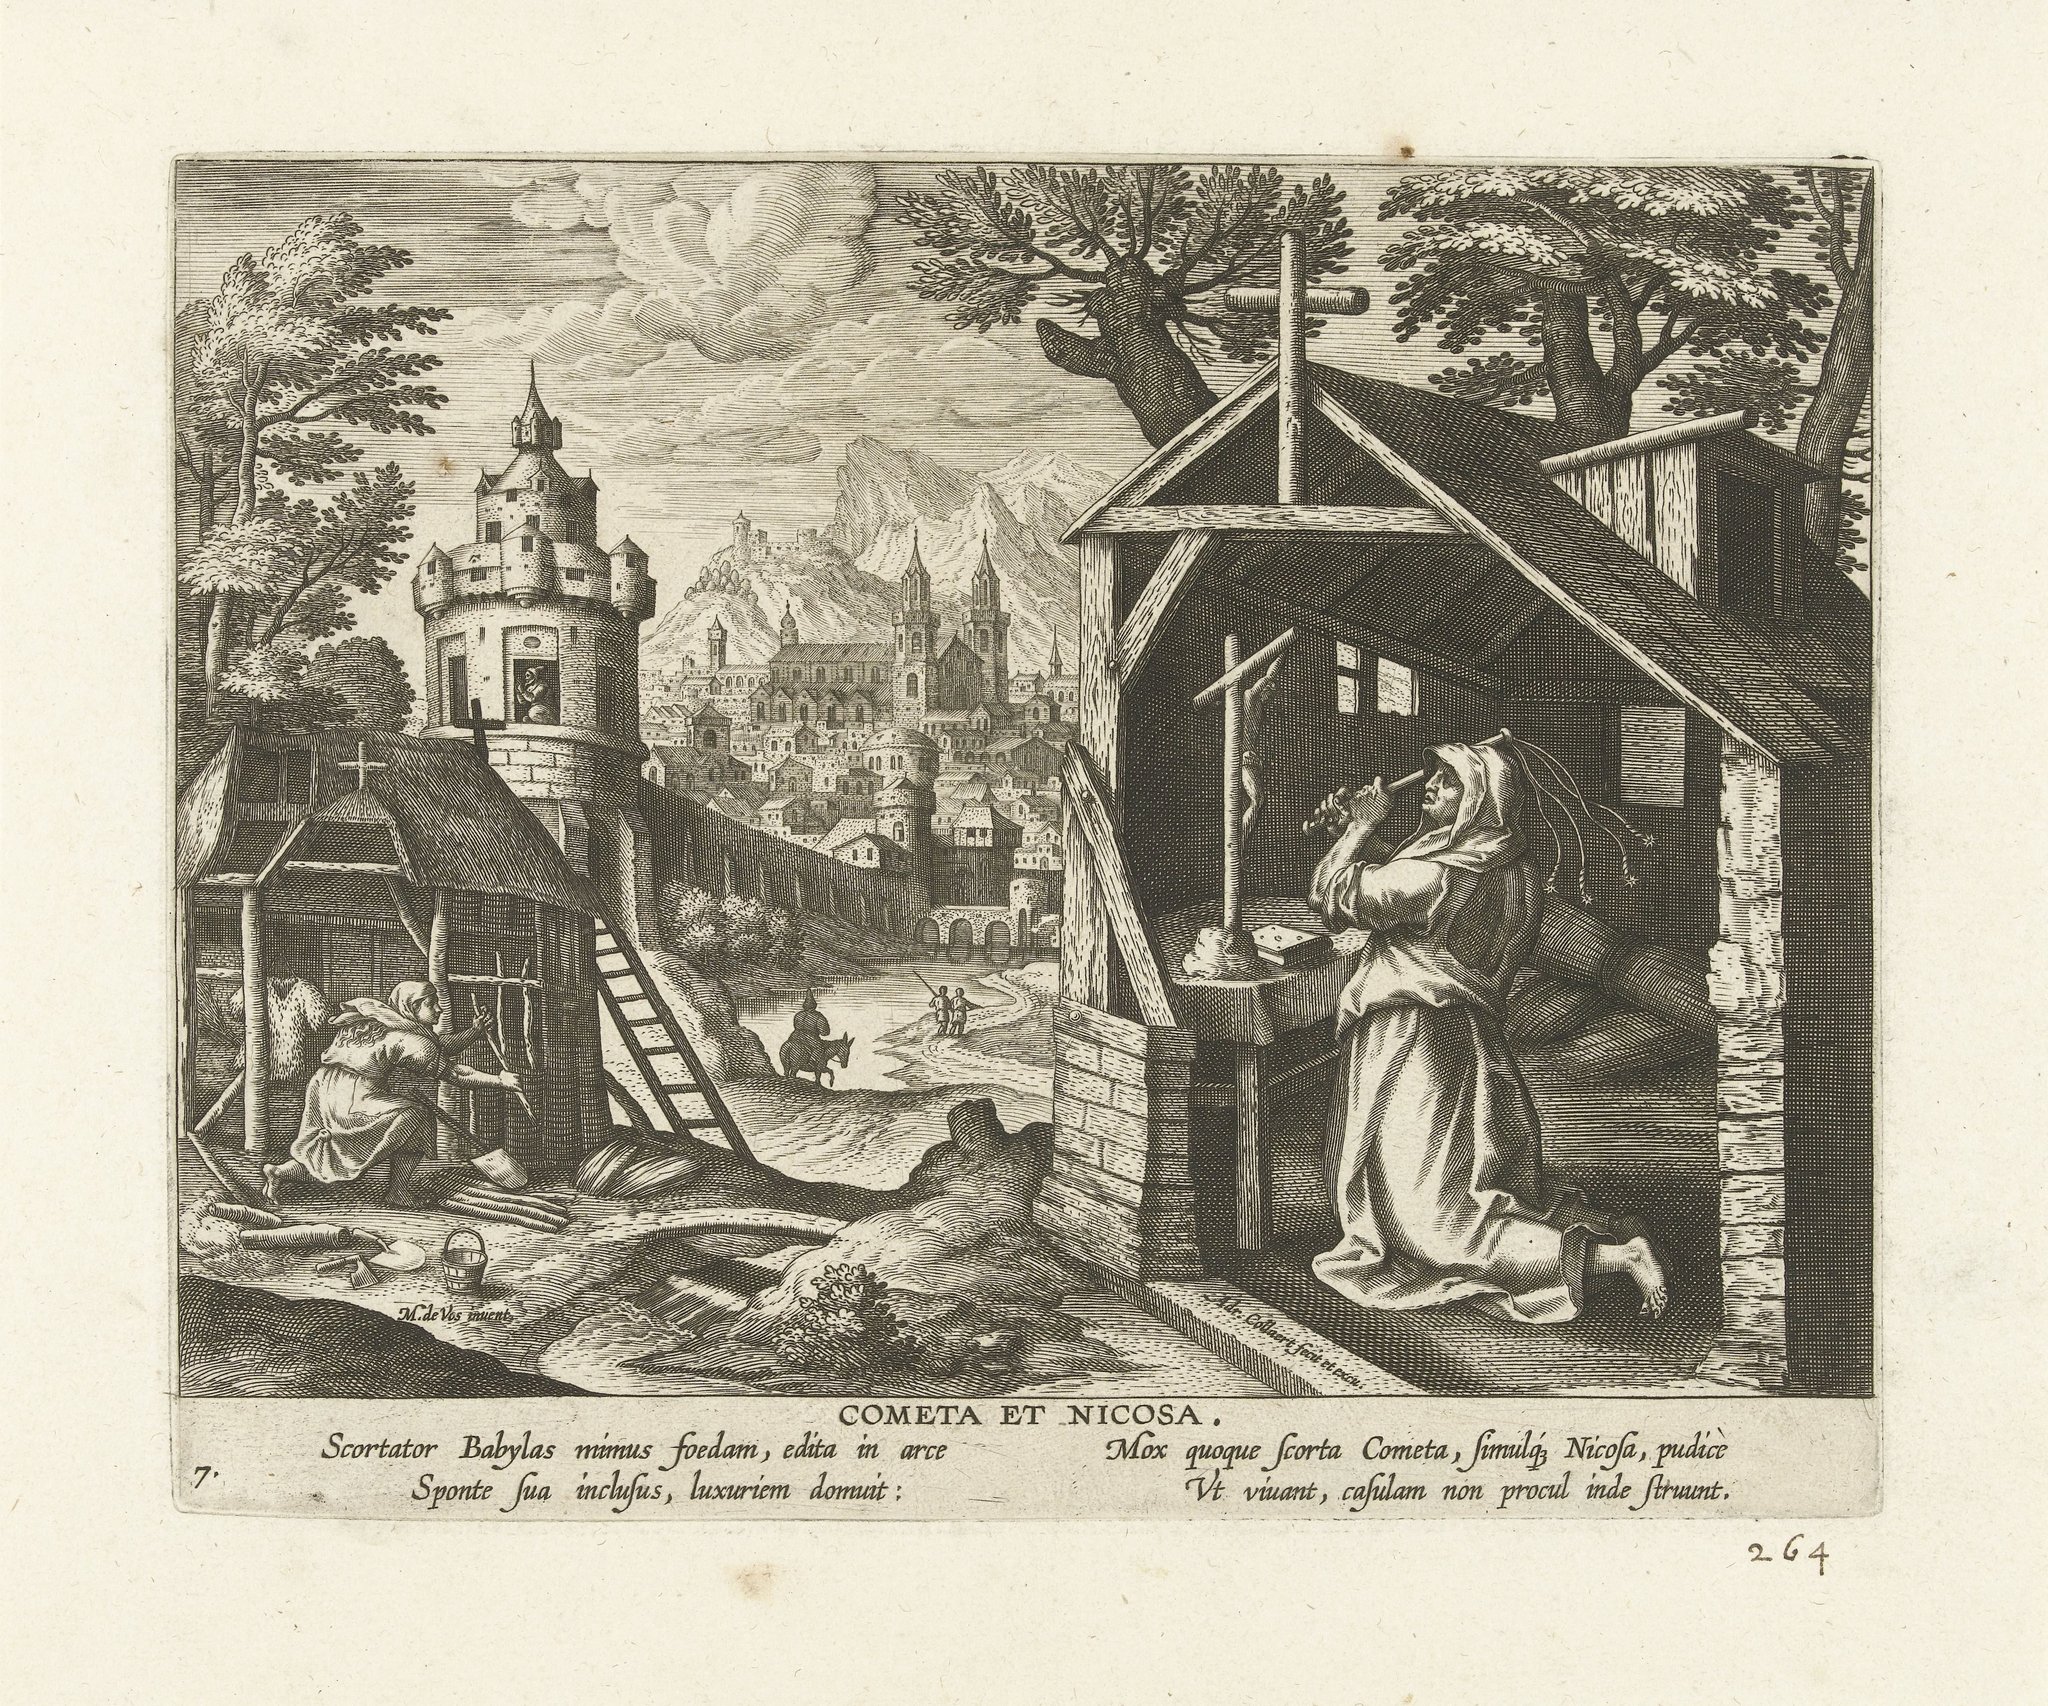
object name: print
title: Cometa en Nicosa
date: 1570-1618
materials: paper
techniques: engraving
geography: antwerp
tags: anchorite, hermit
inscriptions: number: ‘264’, collector's mark: Lugt 2228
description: Cometa en Nicosa, de twee vrouwen van Babylas, kiezen samen met hem voor een leven van onthouding. Babylas is op de achtergrond te zien, biddend in een toren. De twee vrouwen op de voorgrond. De rechterfiguur kastijdt zichzelf voor een kruisbeeld. De linkerfiguur sprokkelt wat hout. De prent heeft een Latijns onderschrift en maakt deel uit van een serie uit vierentwintig prenten met als onderwerp vrouwelijke kluizenaars.